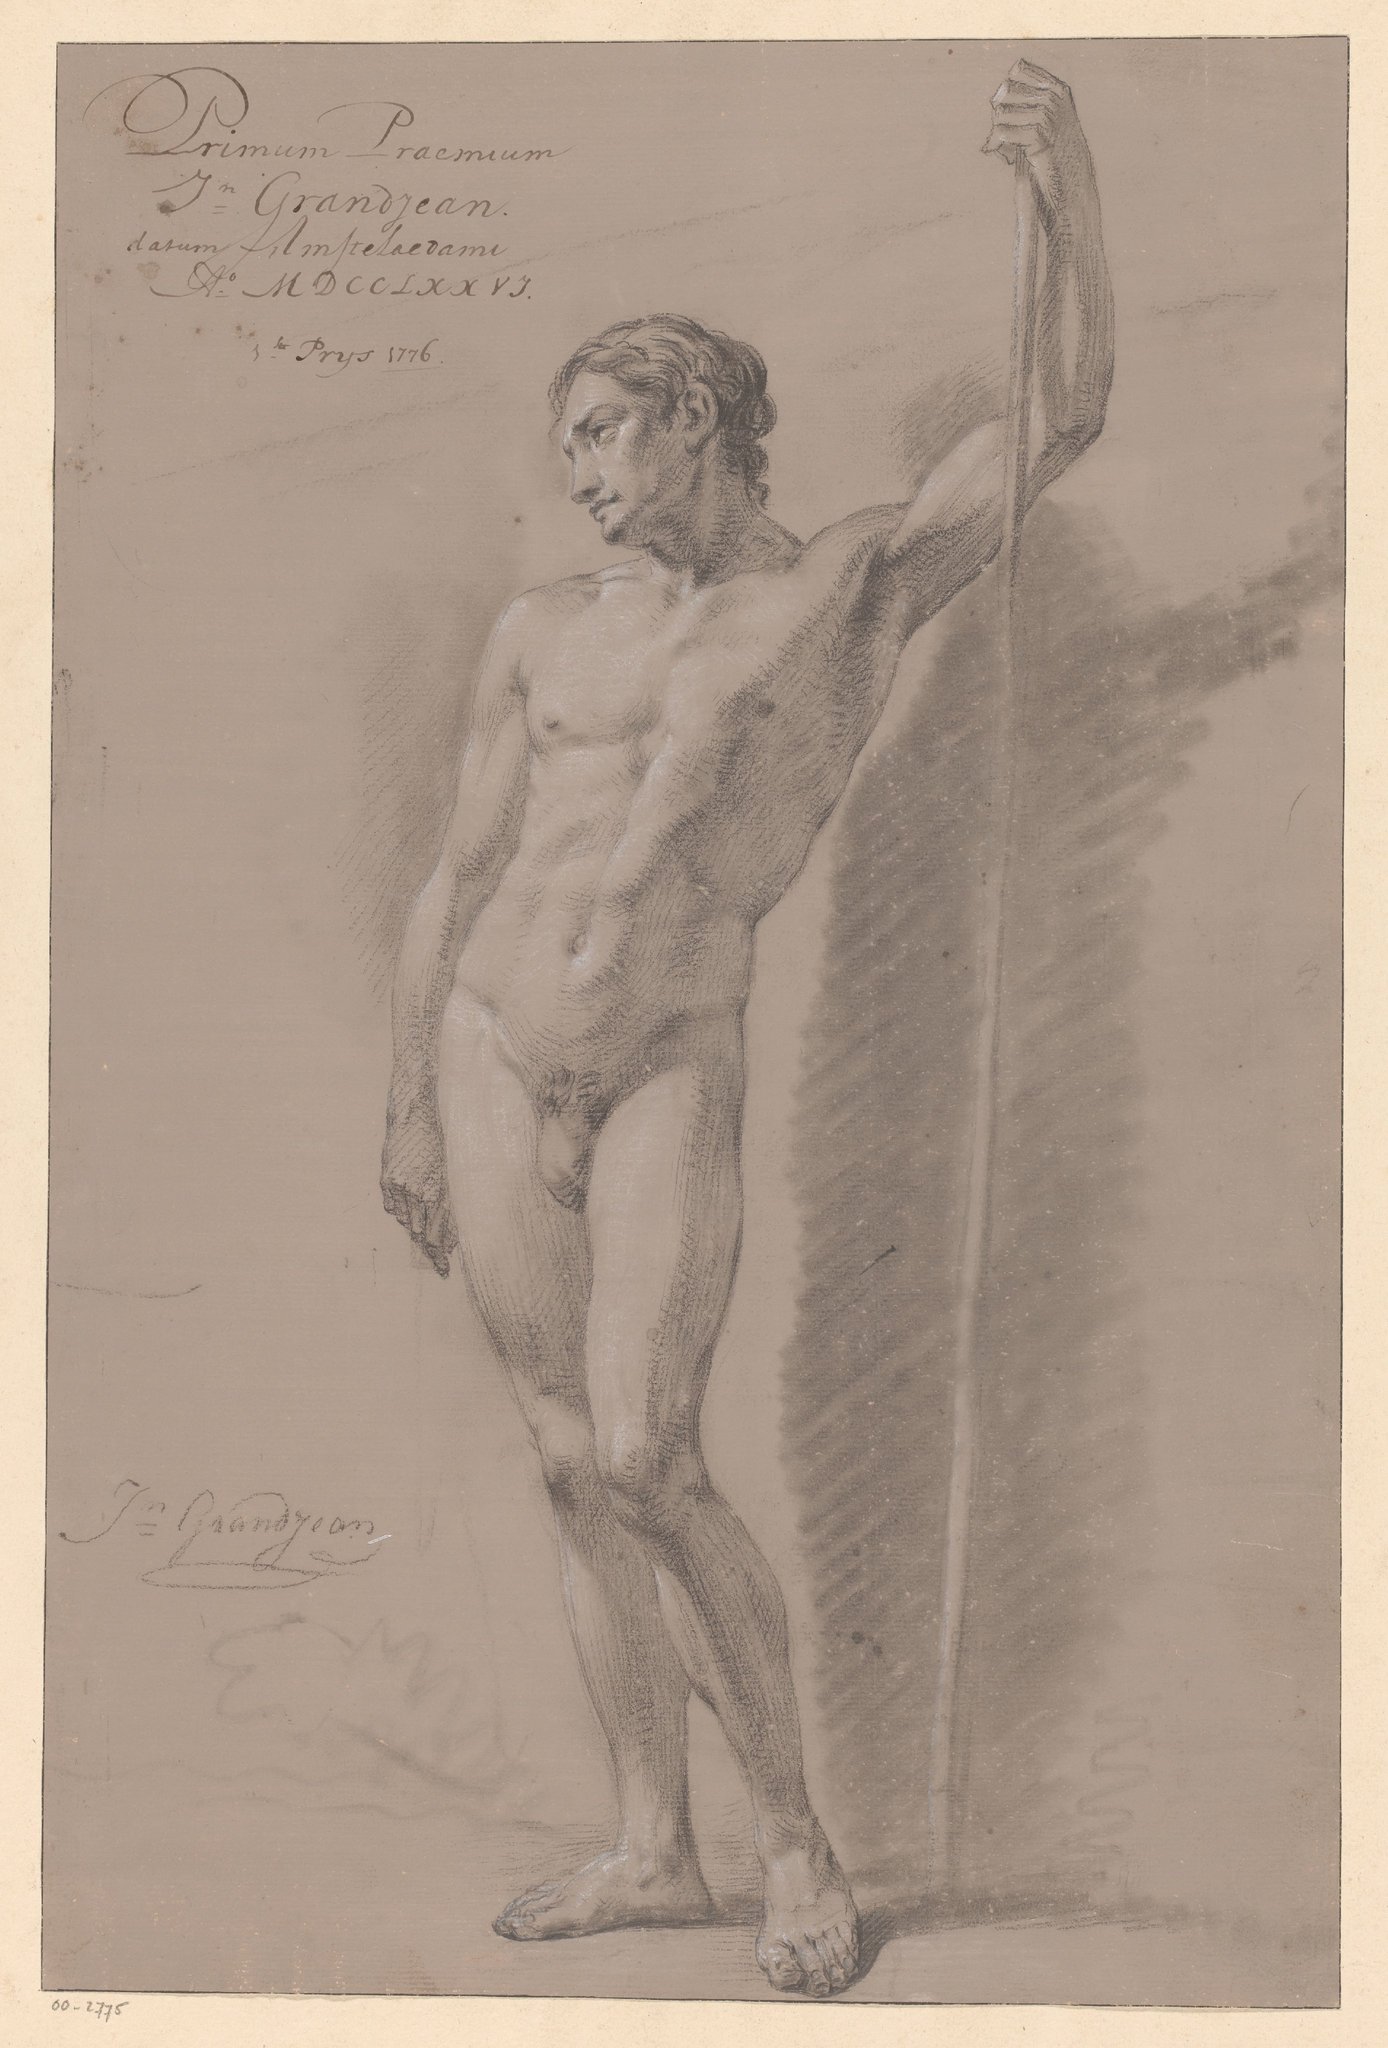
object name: drawing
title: Staand mannelijk naakt, van voren gezien (1e prijs 1776)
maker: jean grandjean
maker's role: draughtsman, print maker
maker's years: 1752-1781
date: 1776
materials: chalk, paper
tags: standing figure (+ nude human being)